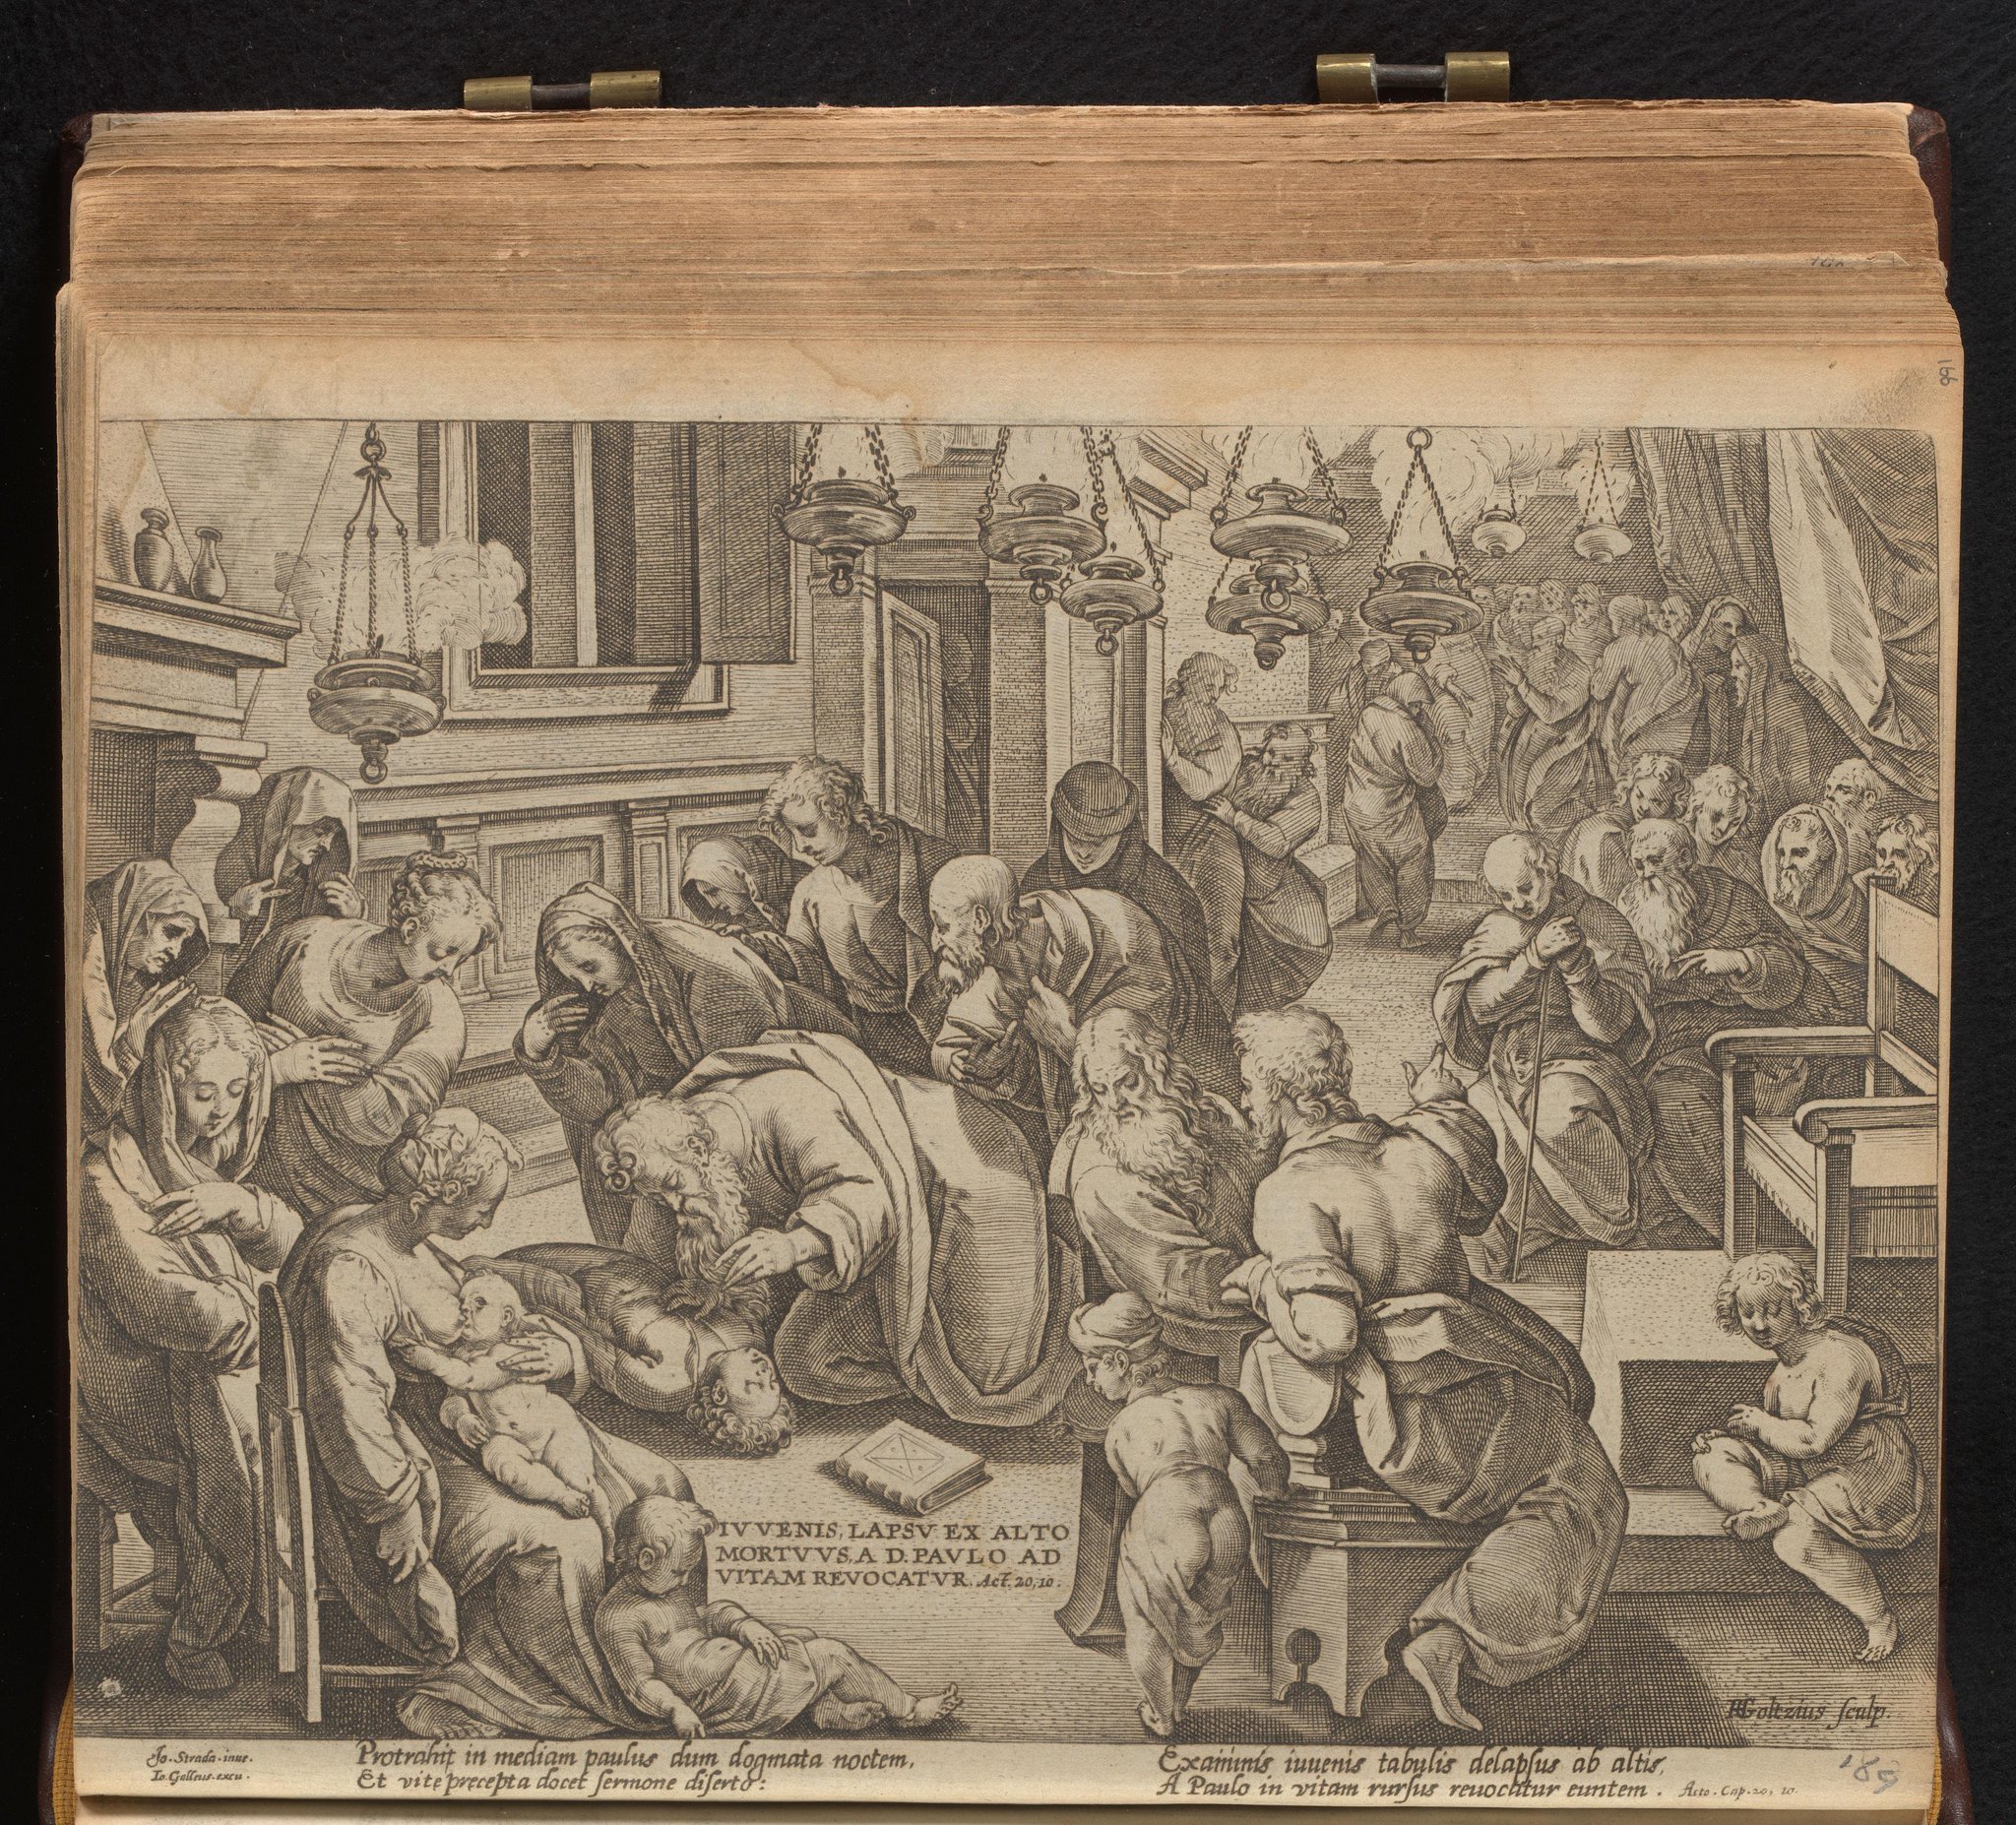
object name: album leaf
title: Paulus wekt Eutychus terug tot leven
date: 1582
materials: paper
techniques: engraving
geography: antwerp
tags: eutychus is raised from the dead by paul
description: Prent maakt deel uit van een prentbijbel.